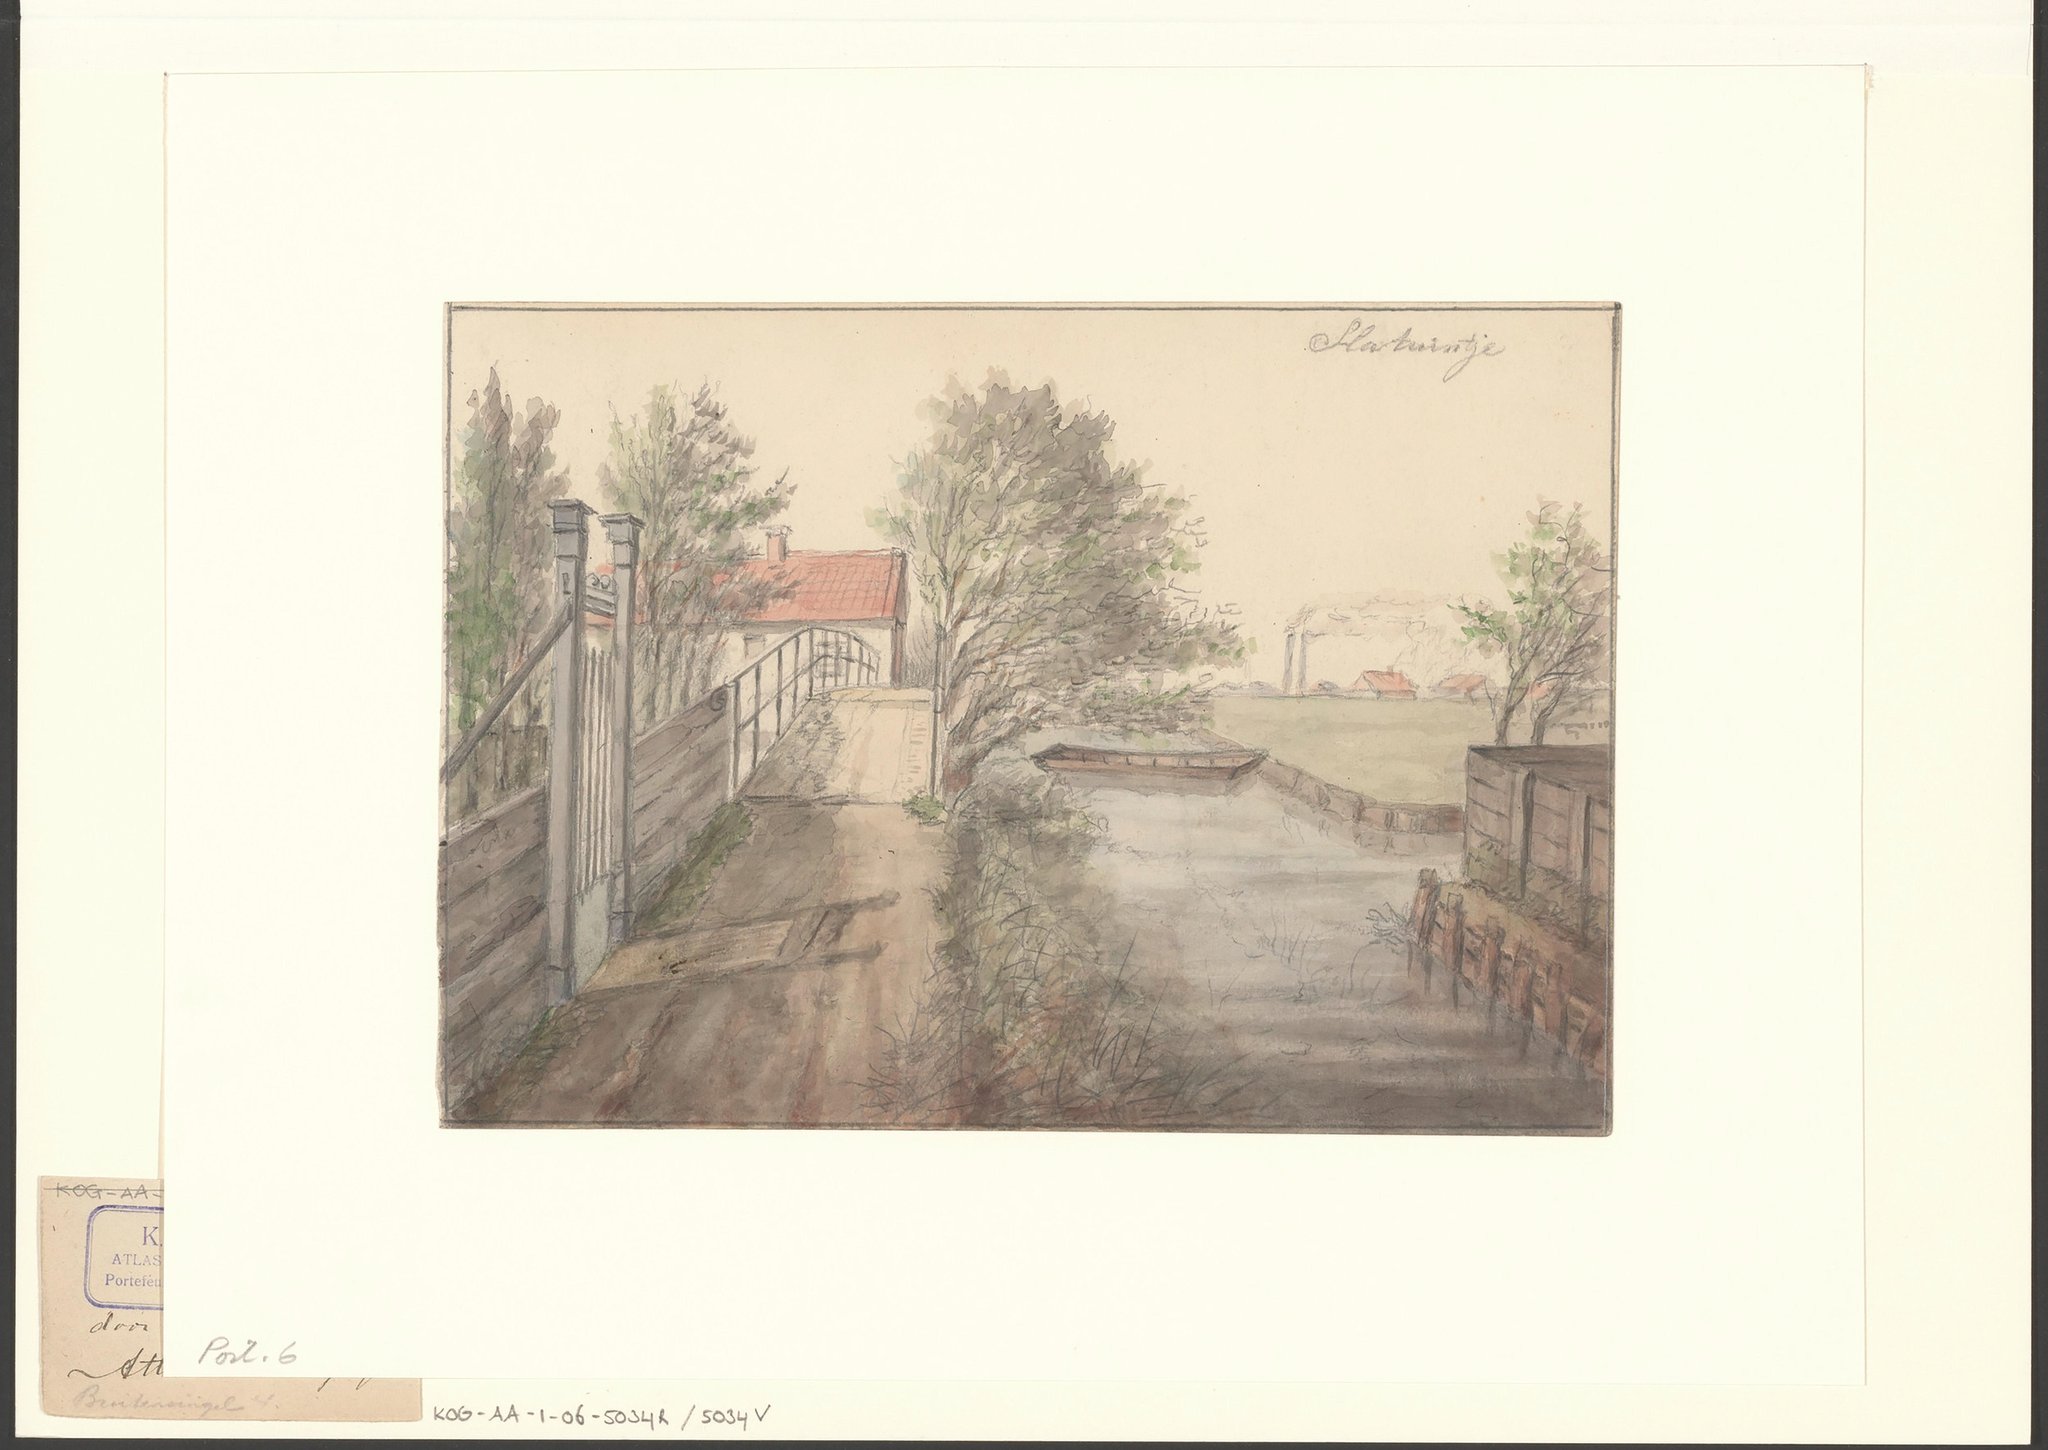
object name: drawing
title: Gezicht op het Slatuinenpad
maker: albert martin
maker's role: draughtsman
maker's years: 1827-1900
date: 1837-1900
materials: paper, pencil, watercolor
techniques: brush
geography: amsterdam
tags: city-view in general; 'veduta', road, path, small canal, ditch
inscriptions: collector's mark: ‘6’ Lugt 1641b, inscription: ‘Slatuintje’, inscription: ‘door A. Martin / Atlas D.C. Meijer Jr’, inscription: ‘Port. 6’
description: Onderwerpsrubriek binnen de Atlas Amsterdam: Buijskade, Catskade (Jacob), Clercqstraat (de), Commelinstraat, Costakade (da), Cuypstraat (Albert), Czaar Peterstraat.